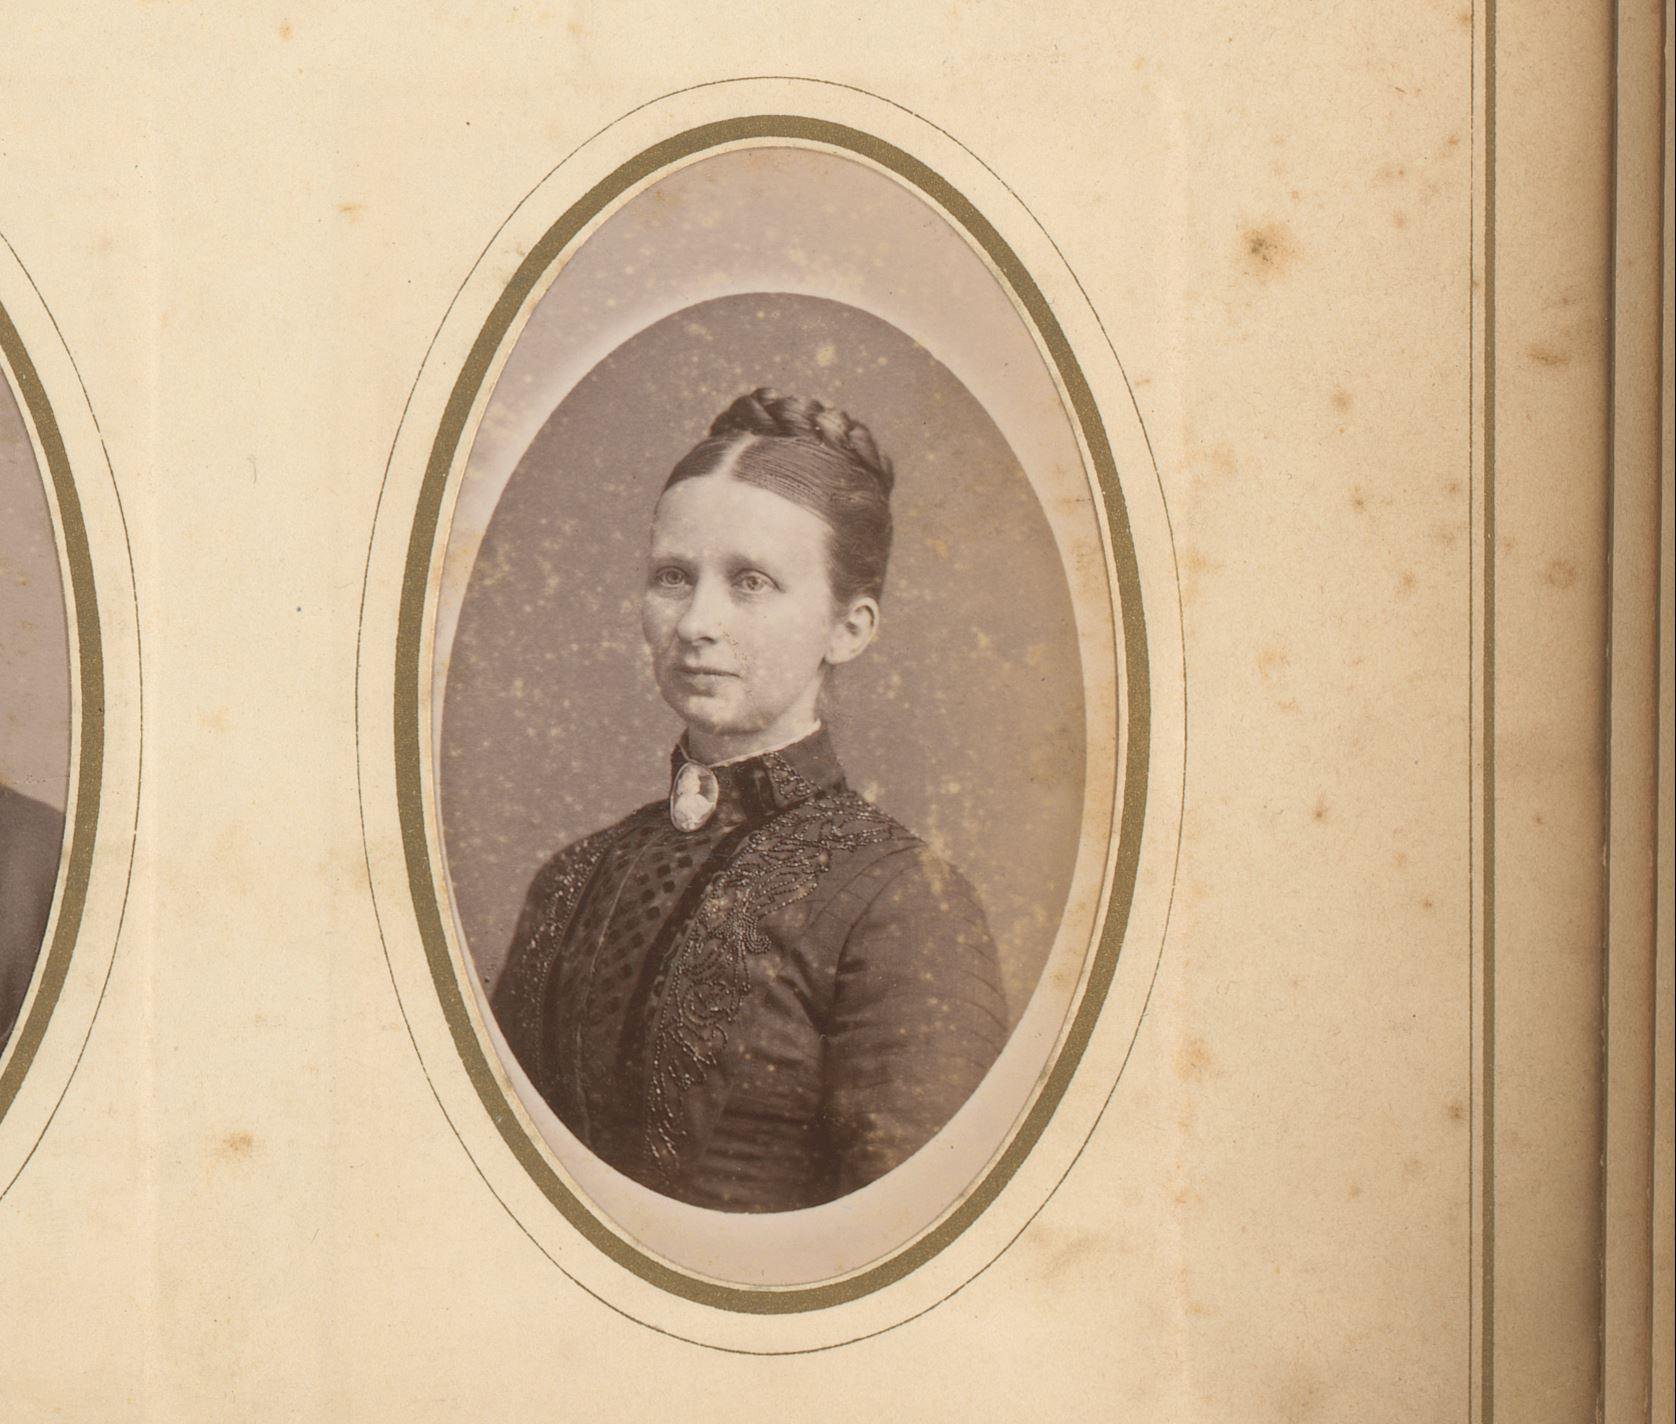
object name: photograph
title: Portret van een vrouw met gevlochten haren en halssieraad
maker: elkan sanders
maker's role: fotograaf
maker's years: 1848-1923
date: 1886-1891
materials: cardboard, photographic support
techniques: albumen print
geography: groningen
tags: historical persons - bb - woman, hairdress, necklace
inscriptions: inscription: ‘Elkan Sanders Jr/ GRONINGEN/ Oosterstraat/ 204./ hoek Donkersgang’